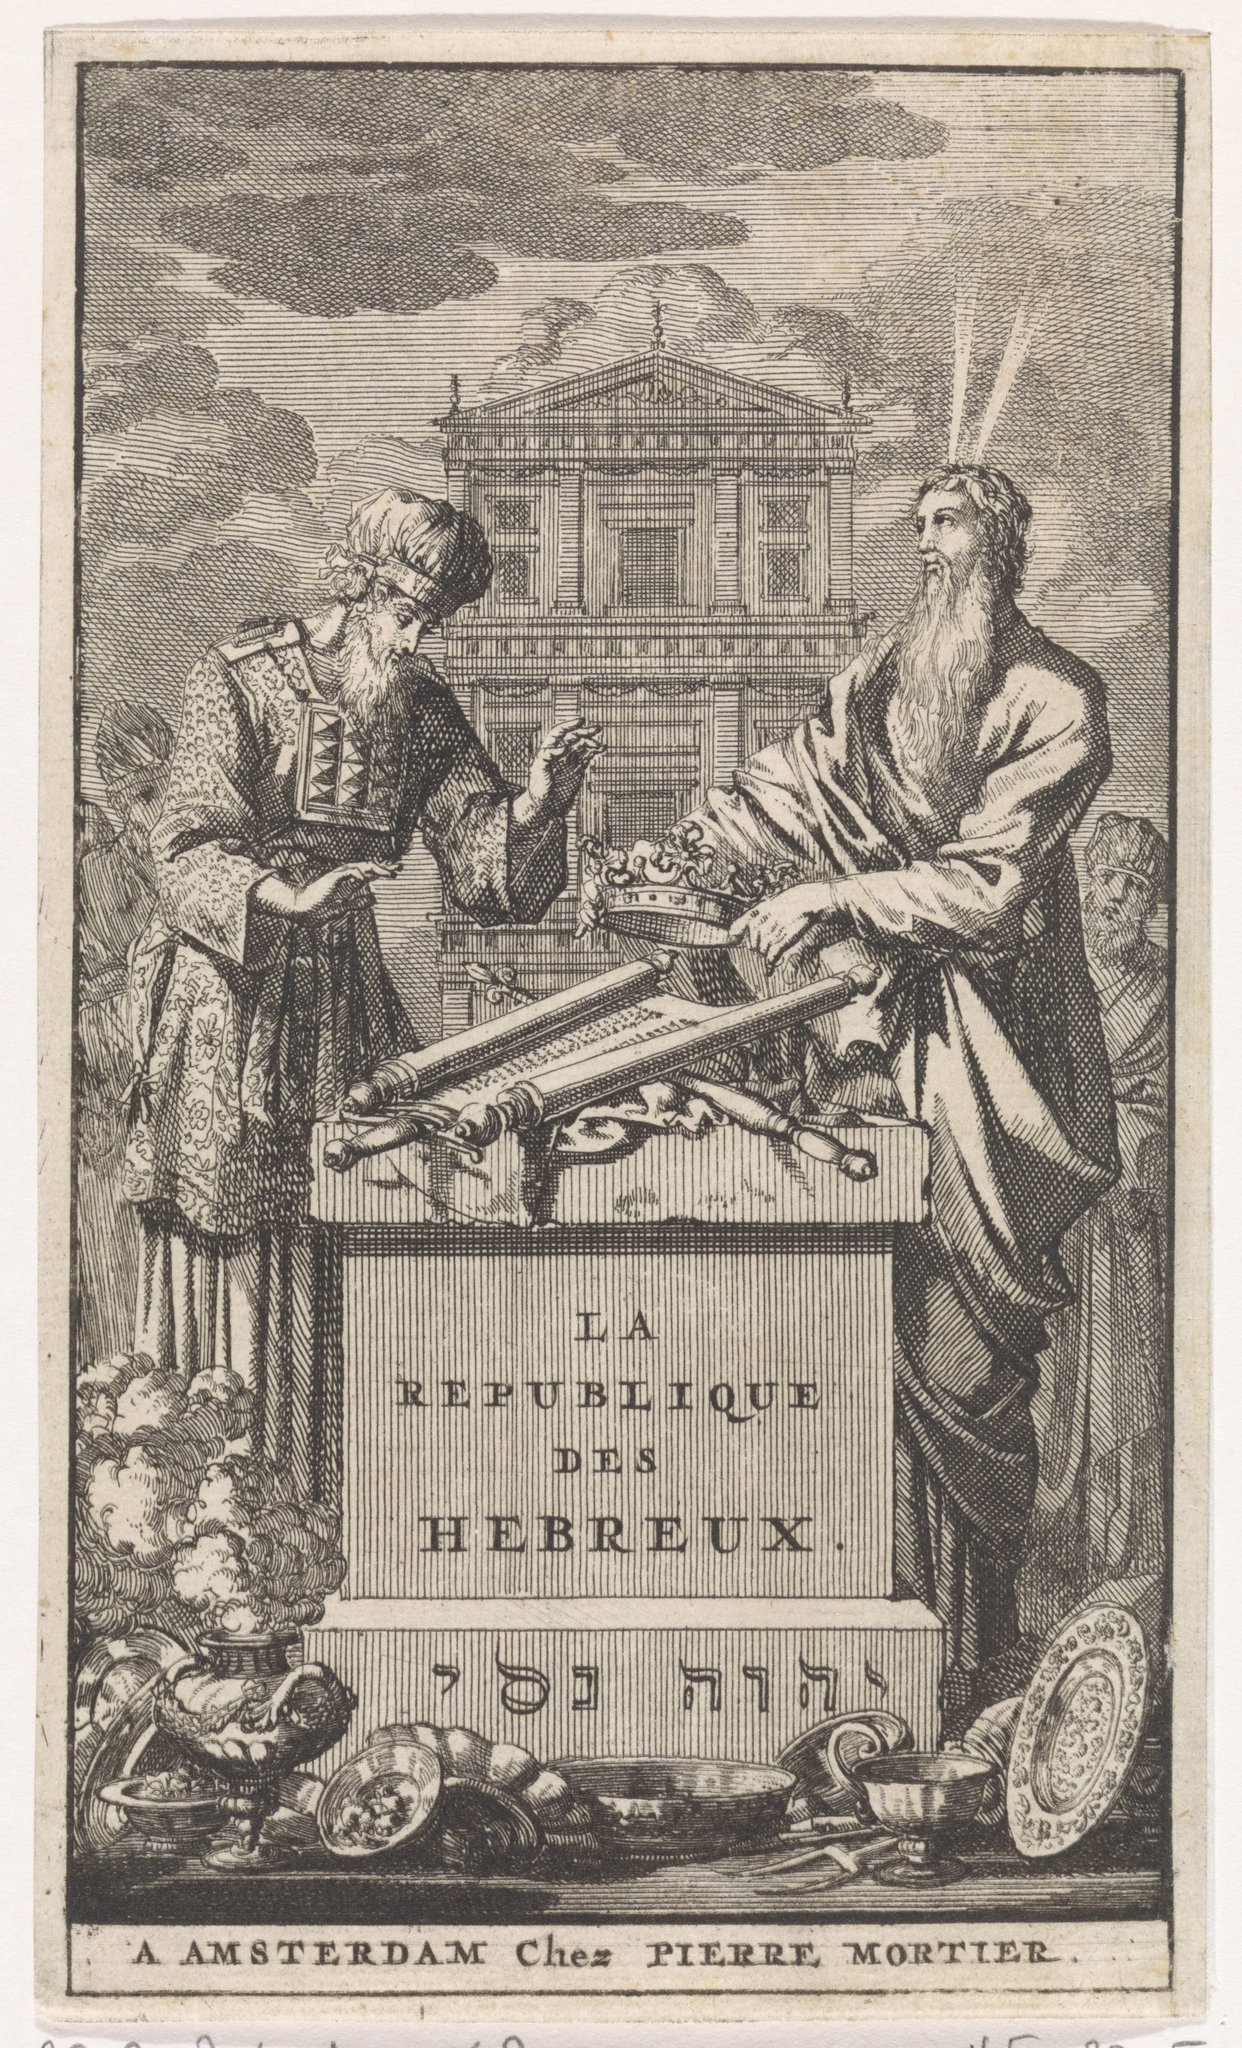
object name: print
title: Titelpagina voor: P. Cunaeus, La republique des Hebreux dl. I, 1705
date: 1705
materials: paper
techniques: etching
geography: amsterdam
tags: aaron (not in biblical context); possible attributes: attributes of aaron: censer, dressed as high priest or bishop, ointment jar, rod or flowering wand, moses (not in biblical context); possible attributes: rays of light or horns on his head, rod, tables of the law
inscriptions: collector's mark: Lugt 2228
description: Titelpagina voor: Cunaeus, Petrus. La republique des Hebreux, 3 delen. Amsterdam: Pieter Mortier, 1705, dl. I.